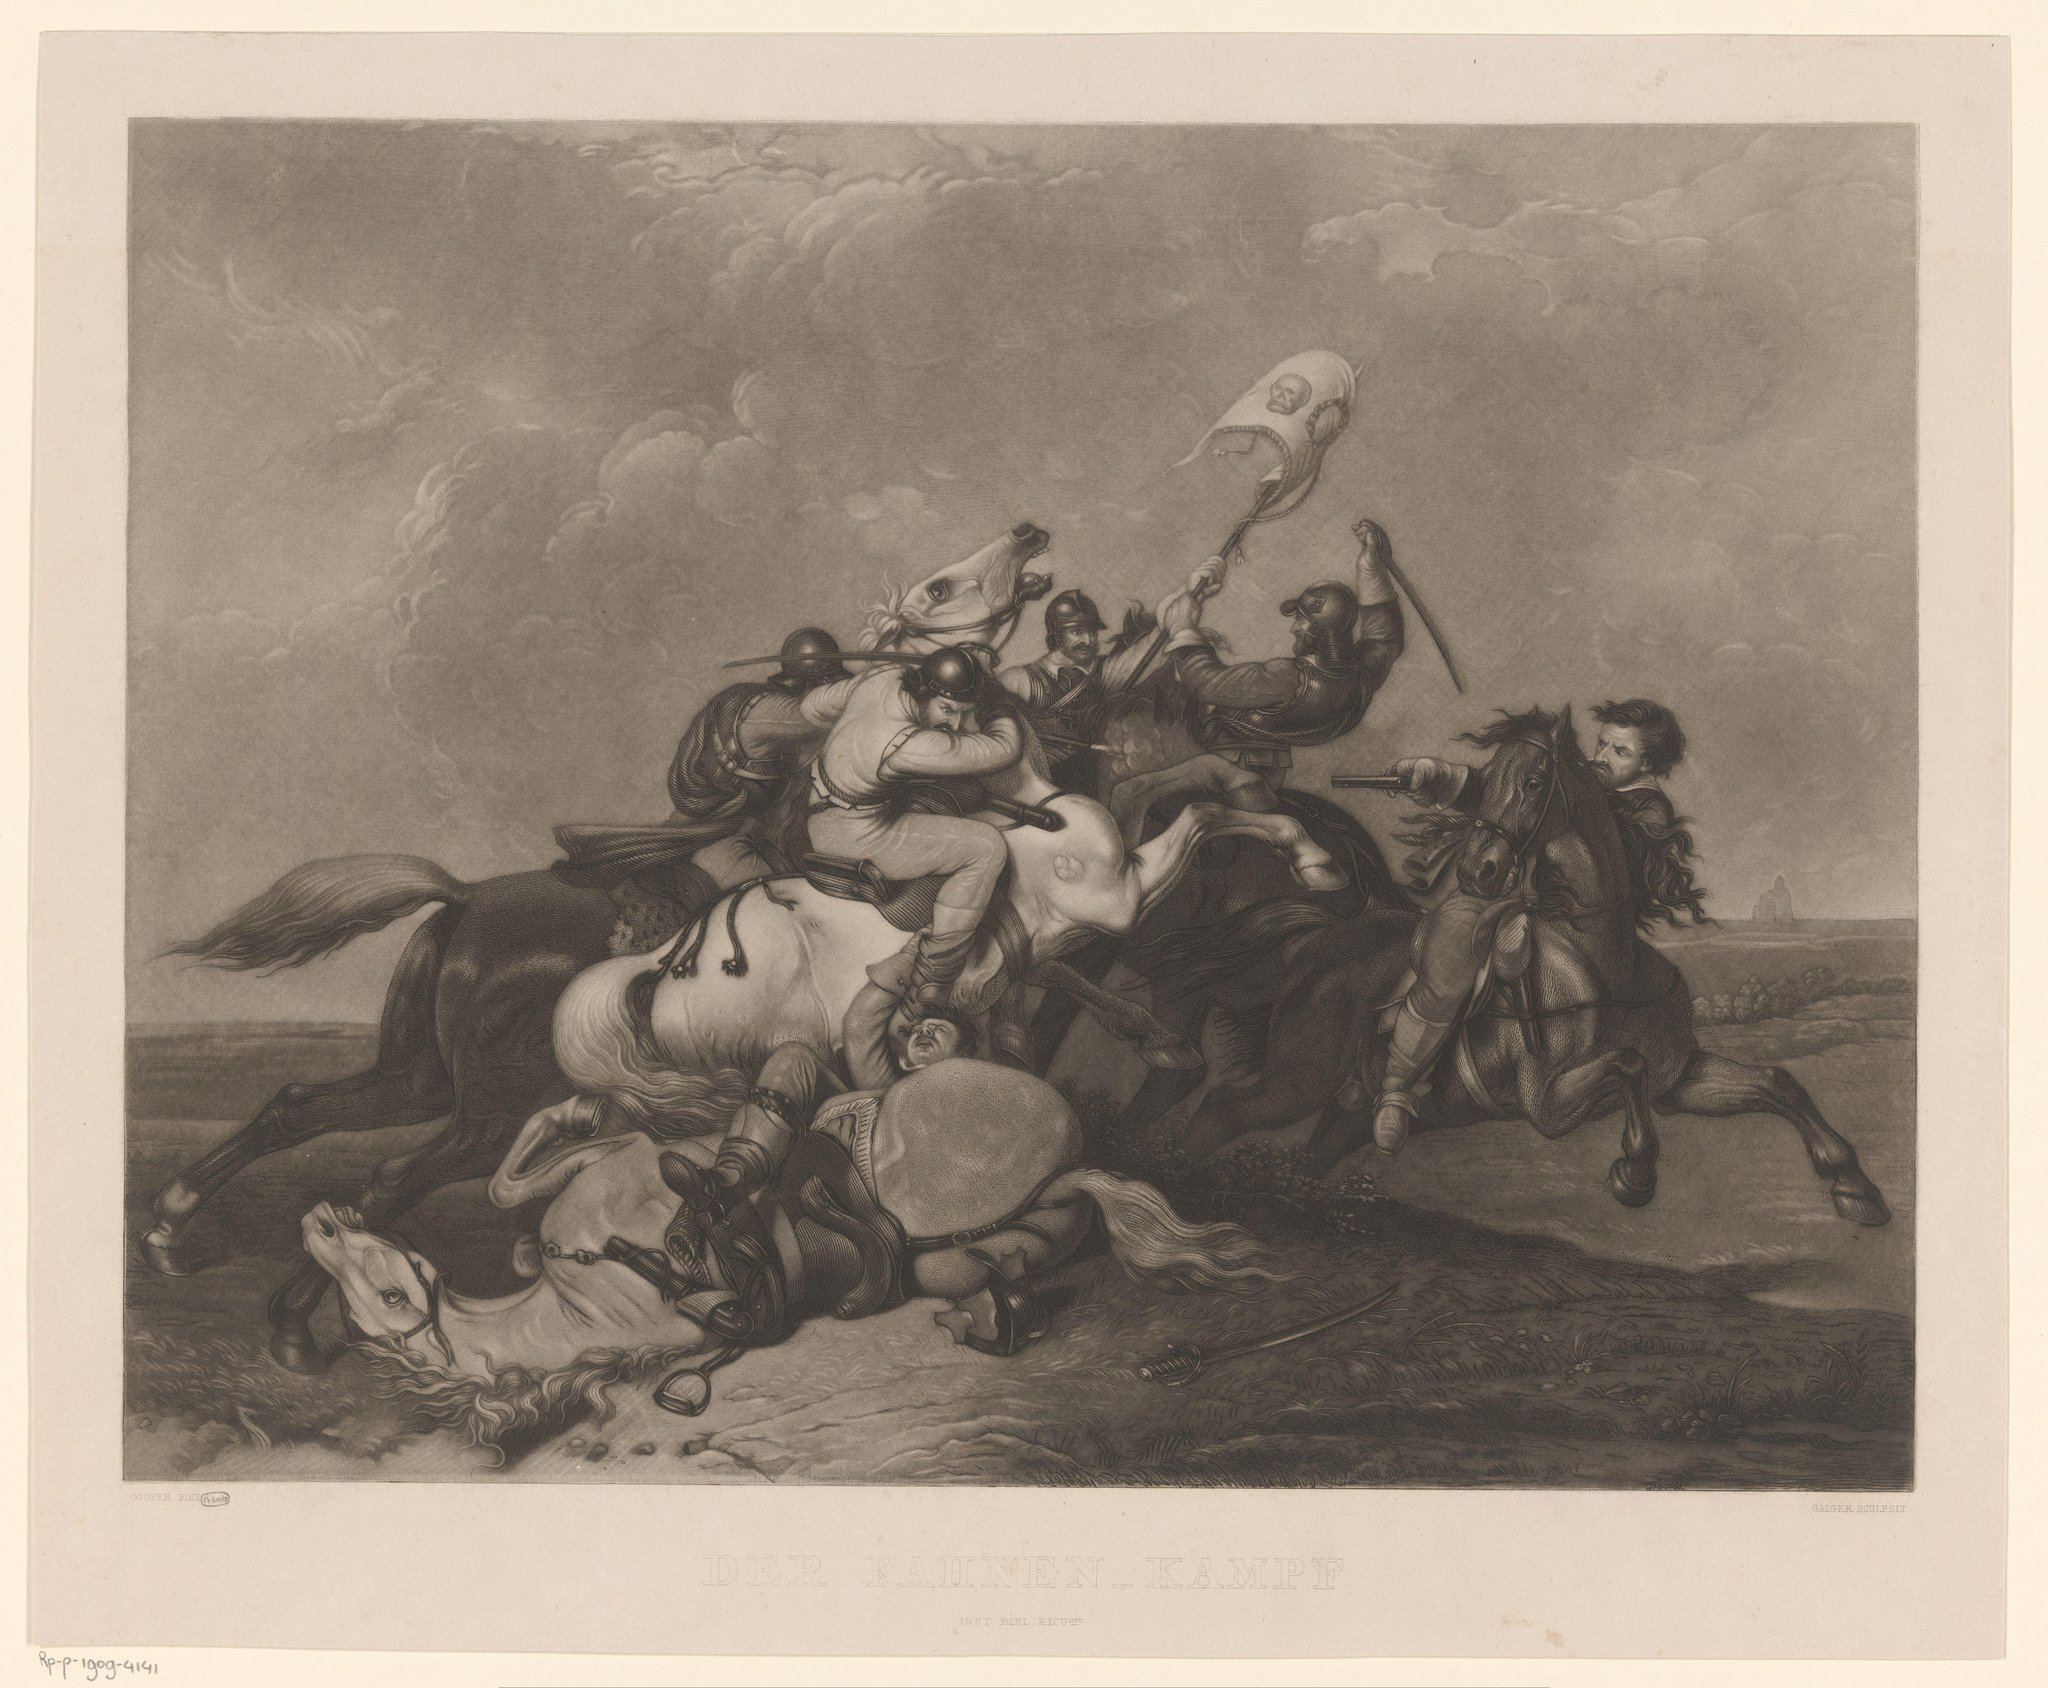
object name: print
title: Der Fahnen-Kampf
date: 1880-1909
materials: paper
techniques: etching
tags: riding a horse, ass, or mule; rider, horseman, battle, (military) flags and standards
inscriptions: collector's mark: ‘Prämi[...]’, collector's mark: Lugt 2228